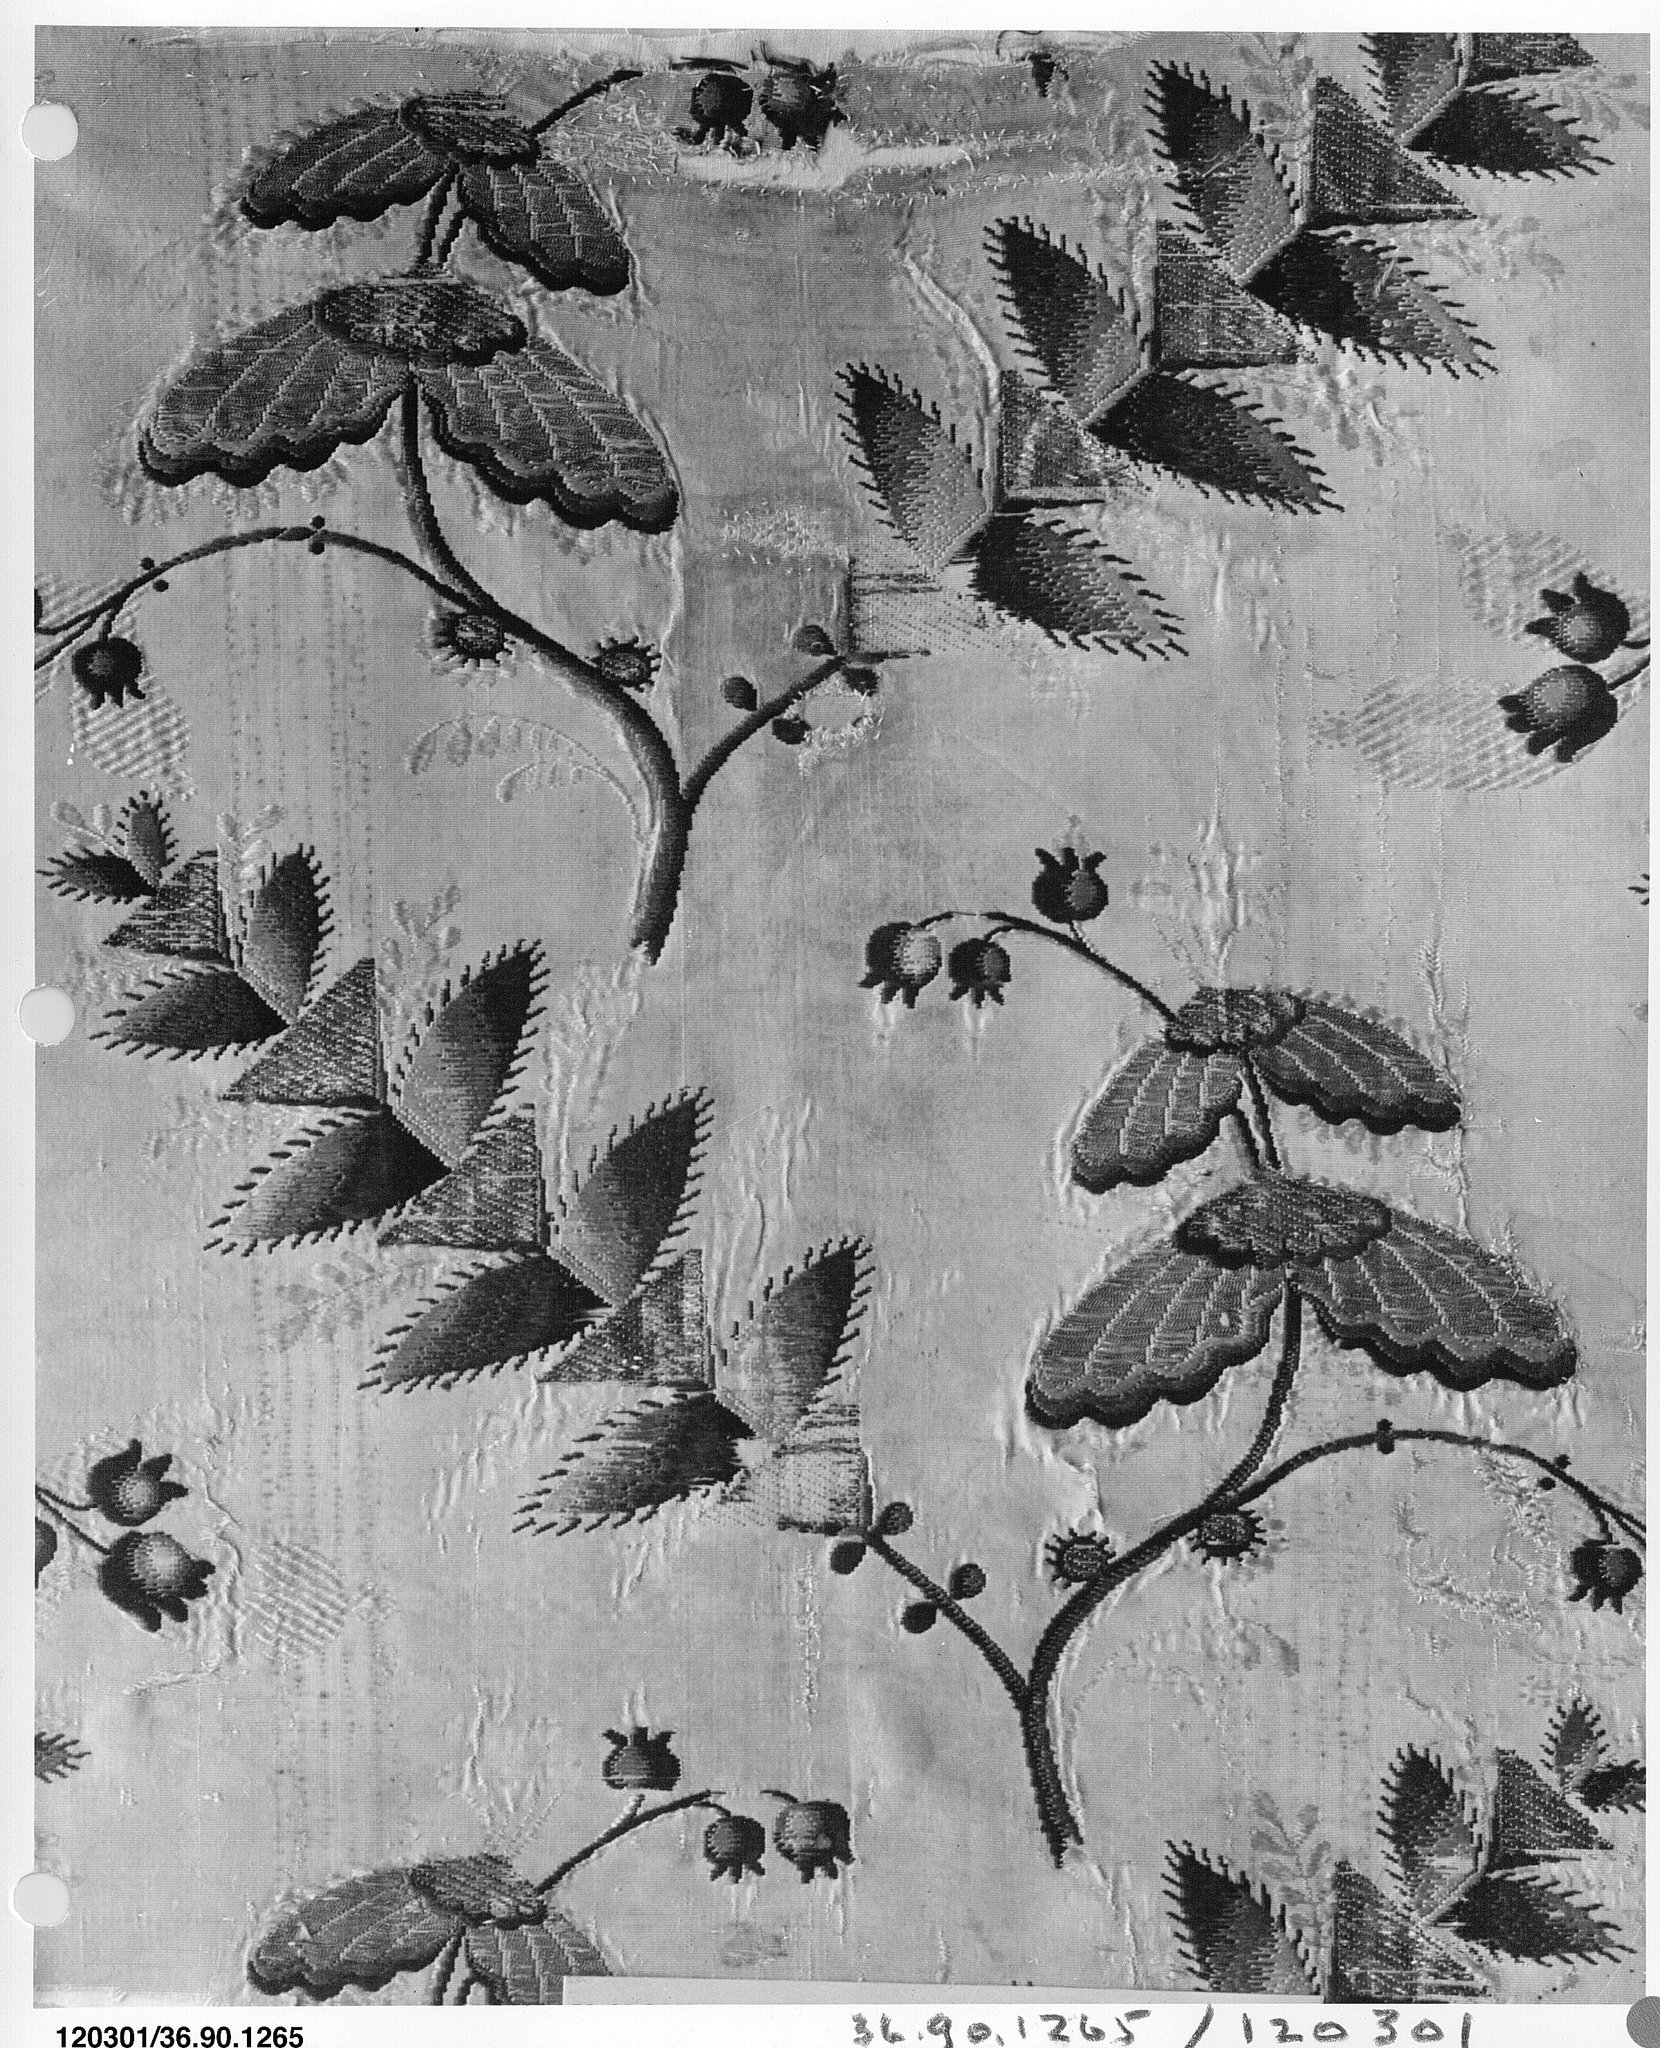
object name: piece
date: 1760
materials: metal thread, silk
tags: flowers